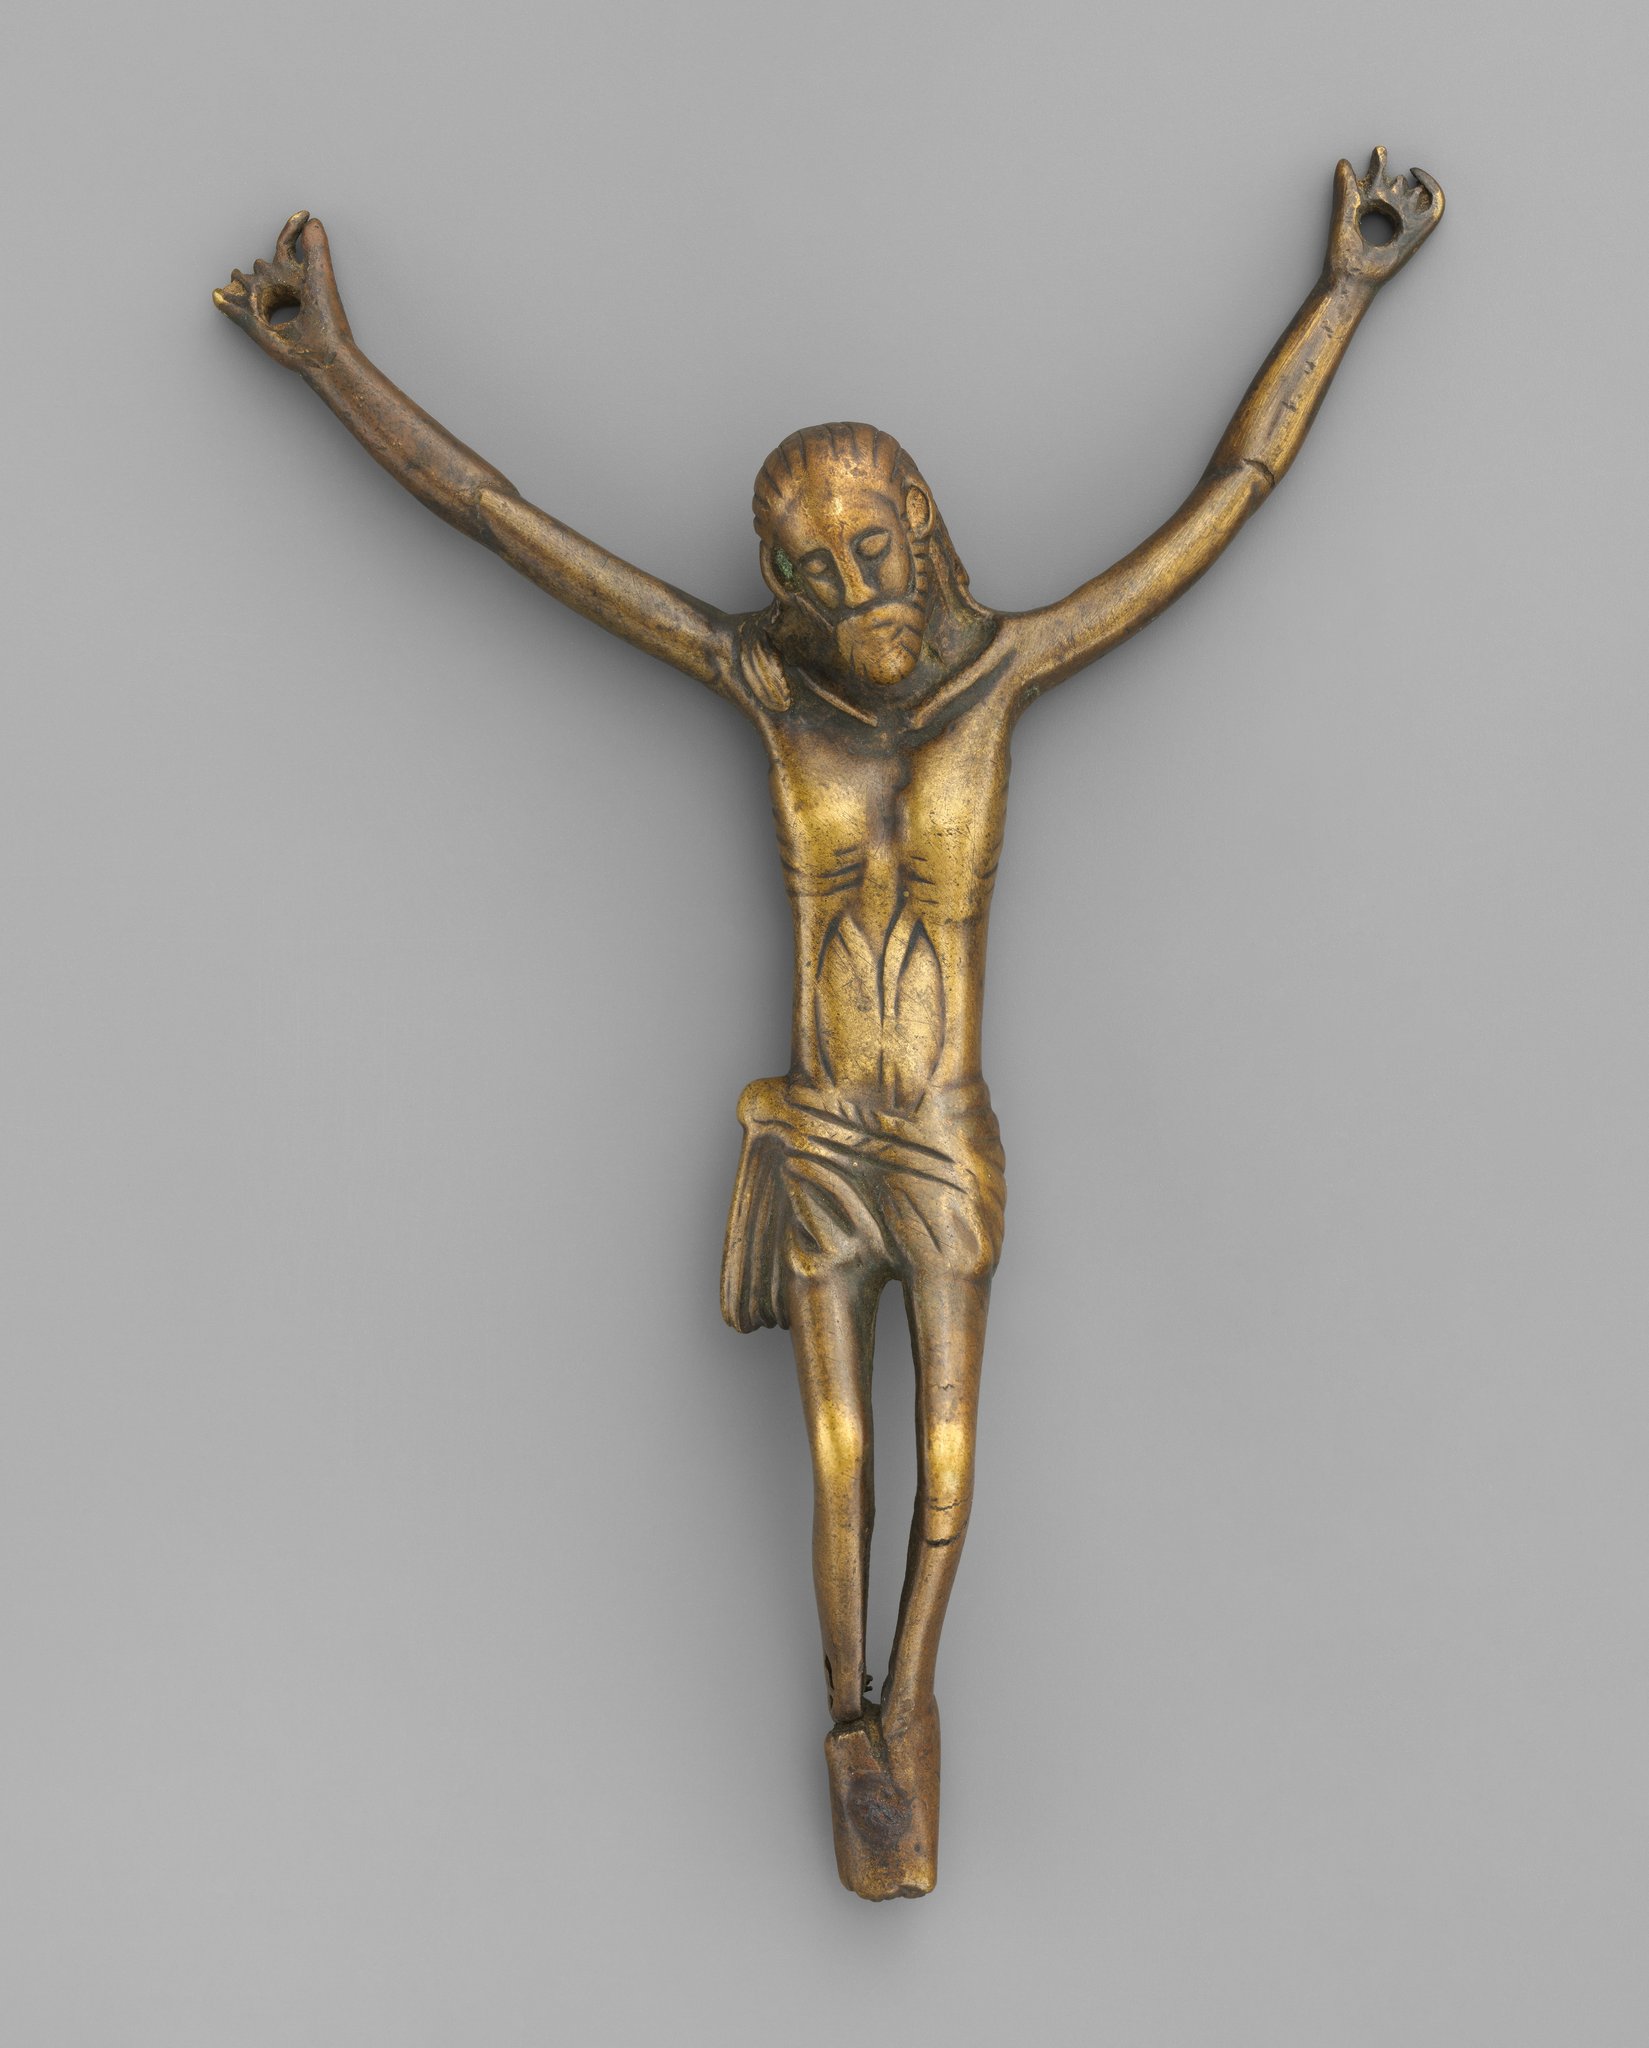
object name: figure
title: Christ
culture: kongo, kongo kingdom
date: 1701-1900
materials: brass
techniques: casting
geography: angola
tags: christ,crucifixion